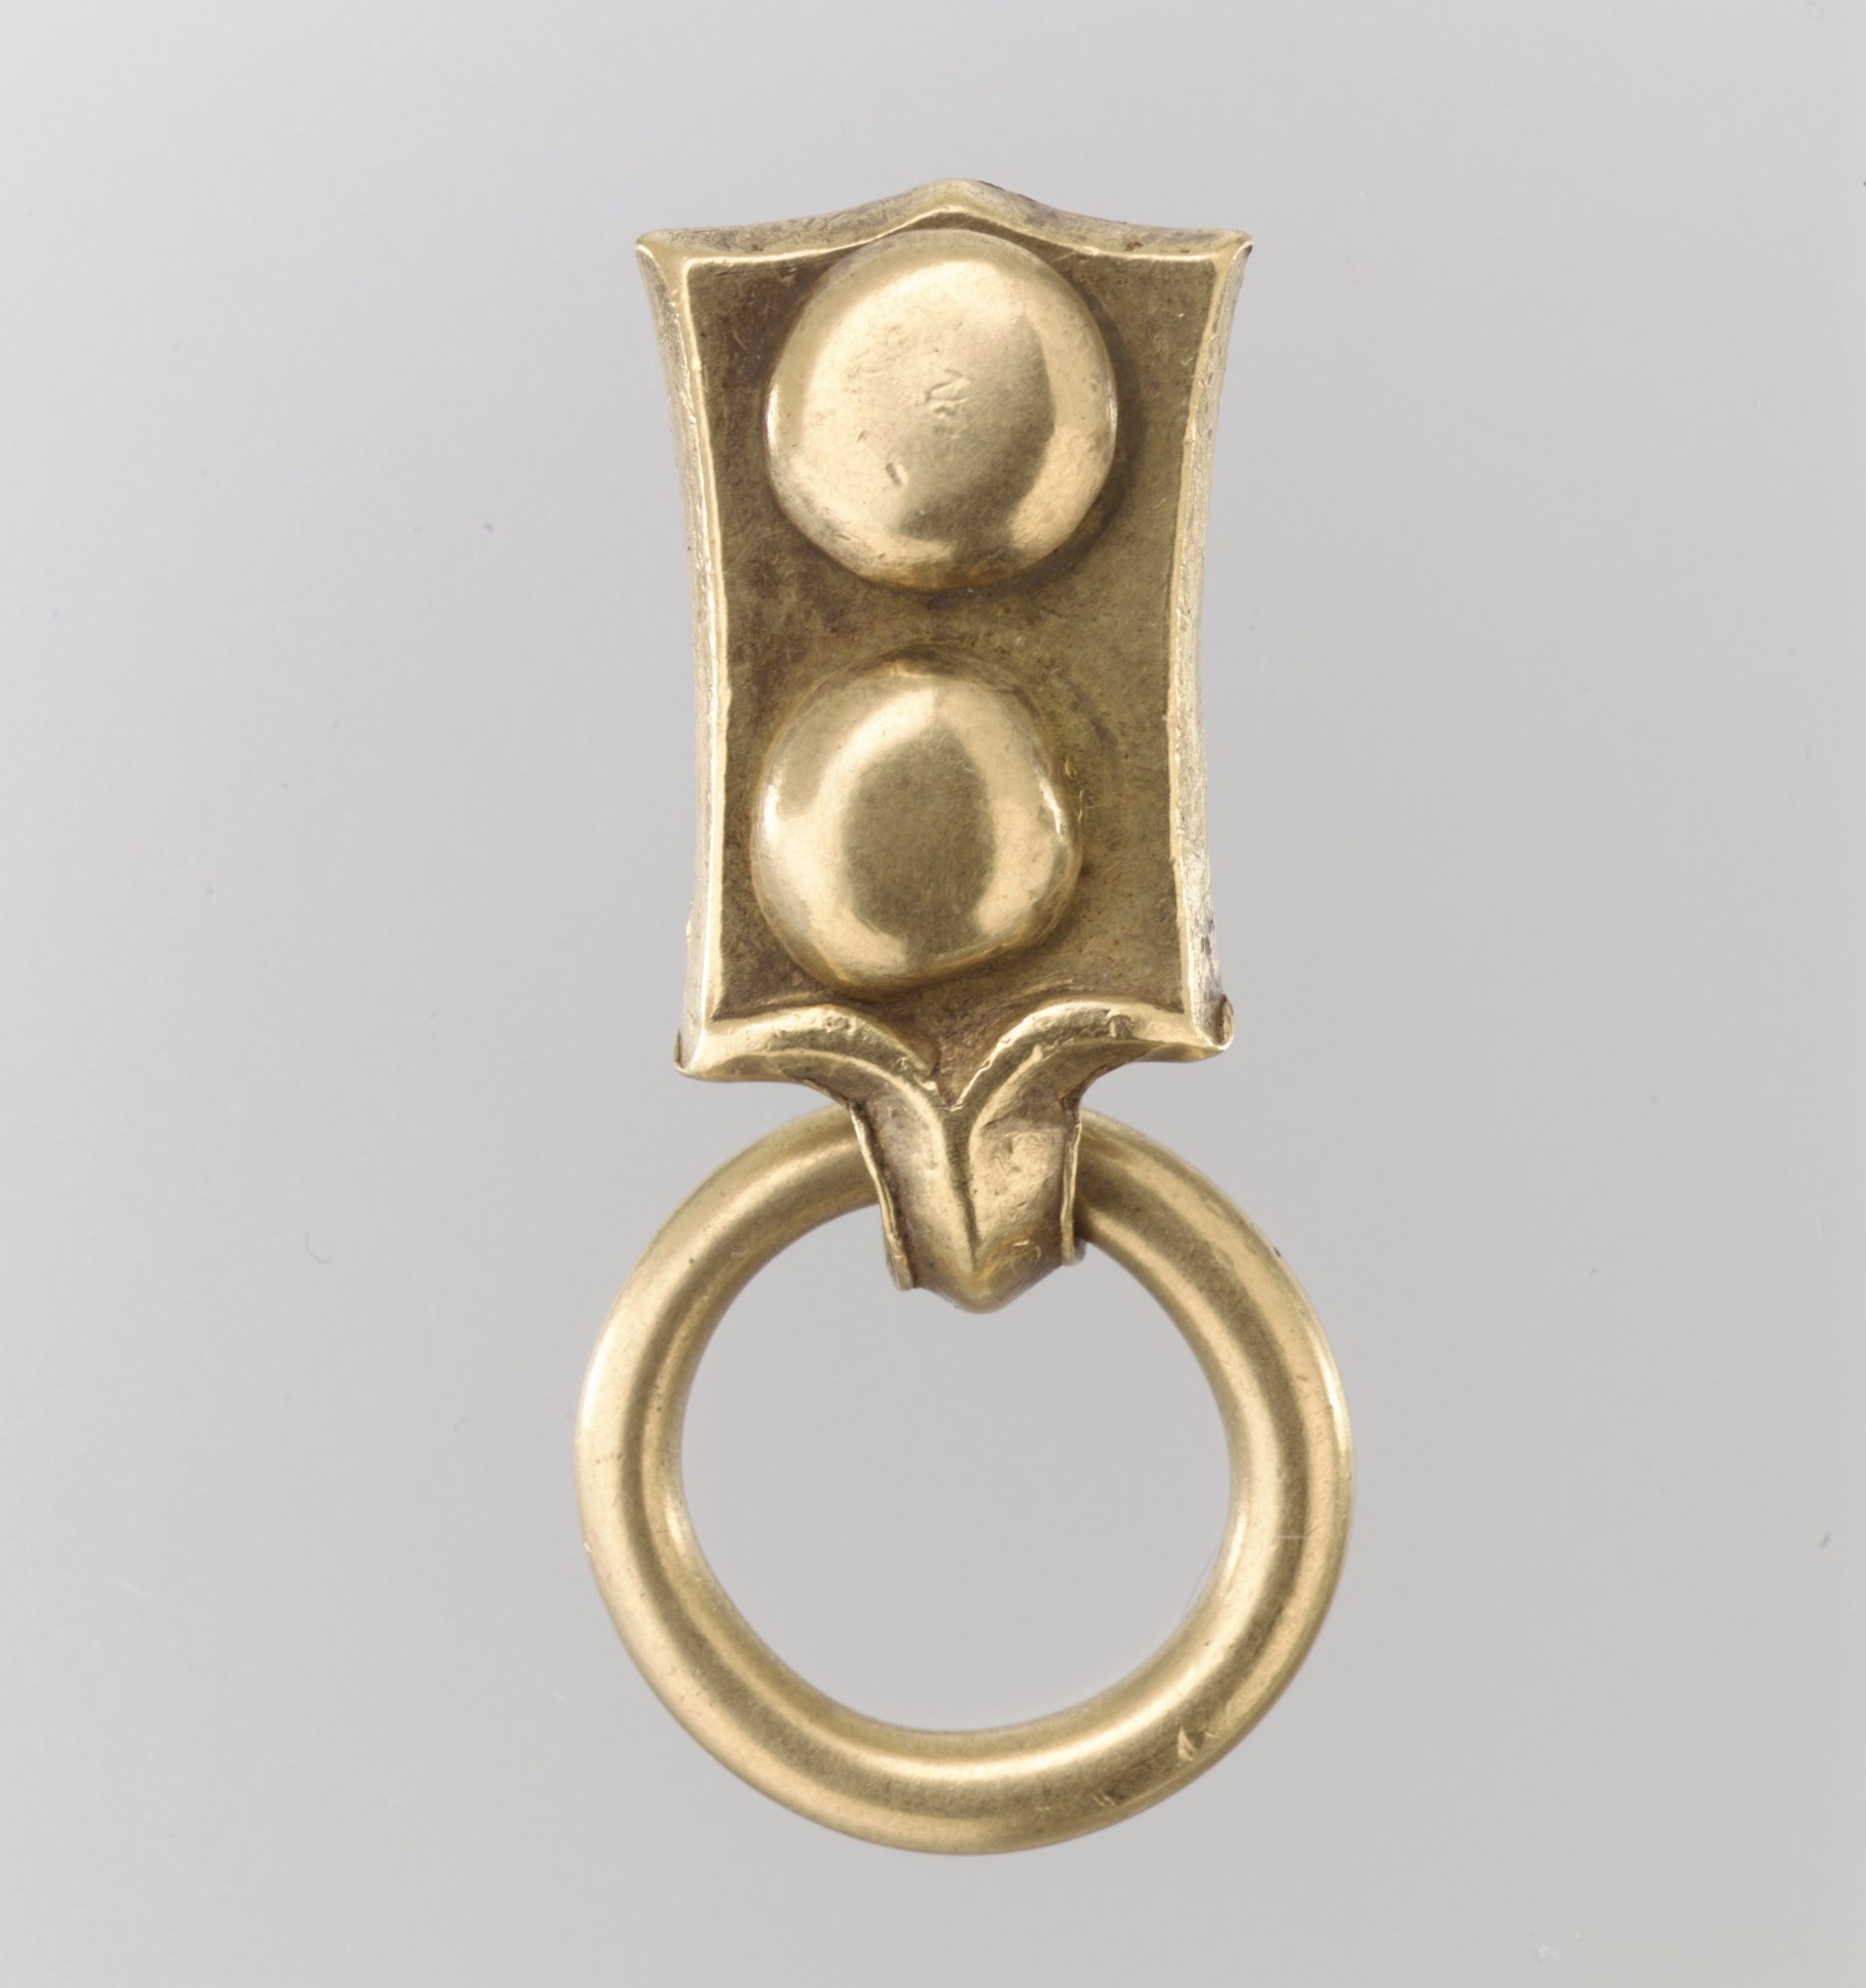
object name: belt mount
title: Gold Belt Mount with Loop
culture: avar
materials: gold